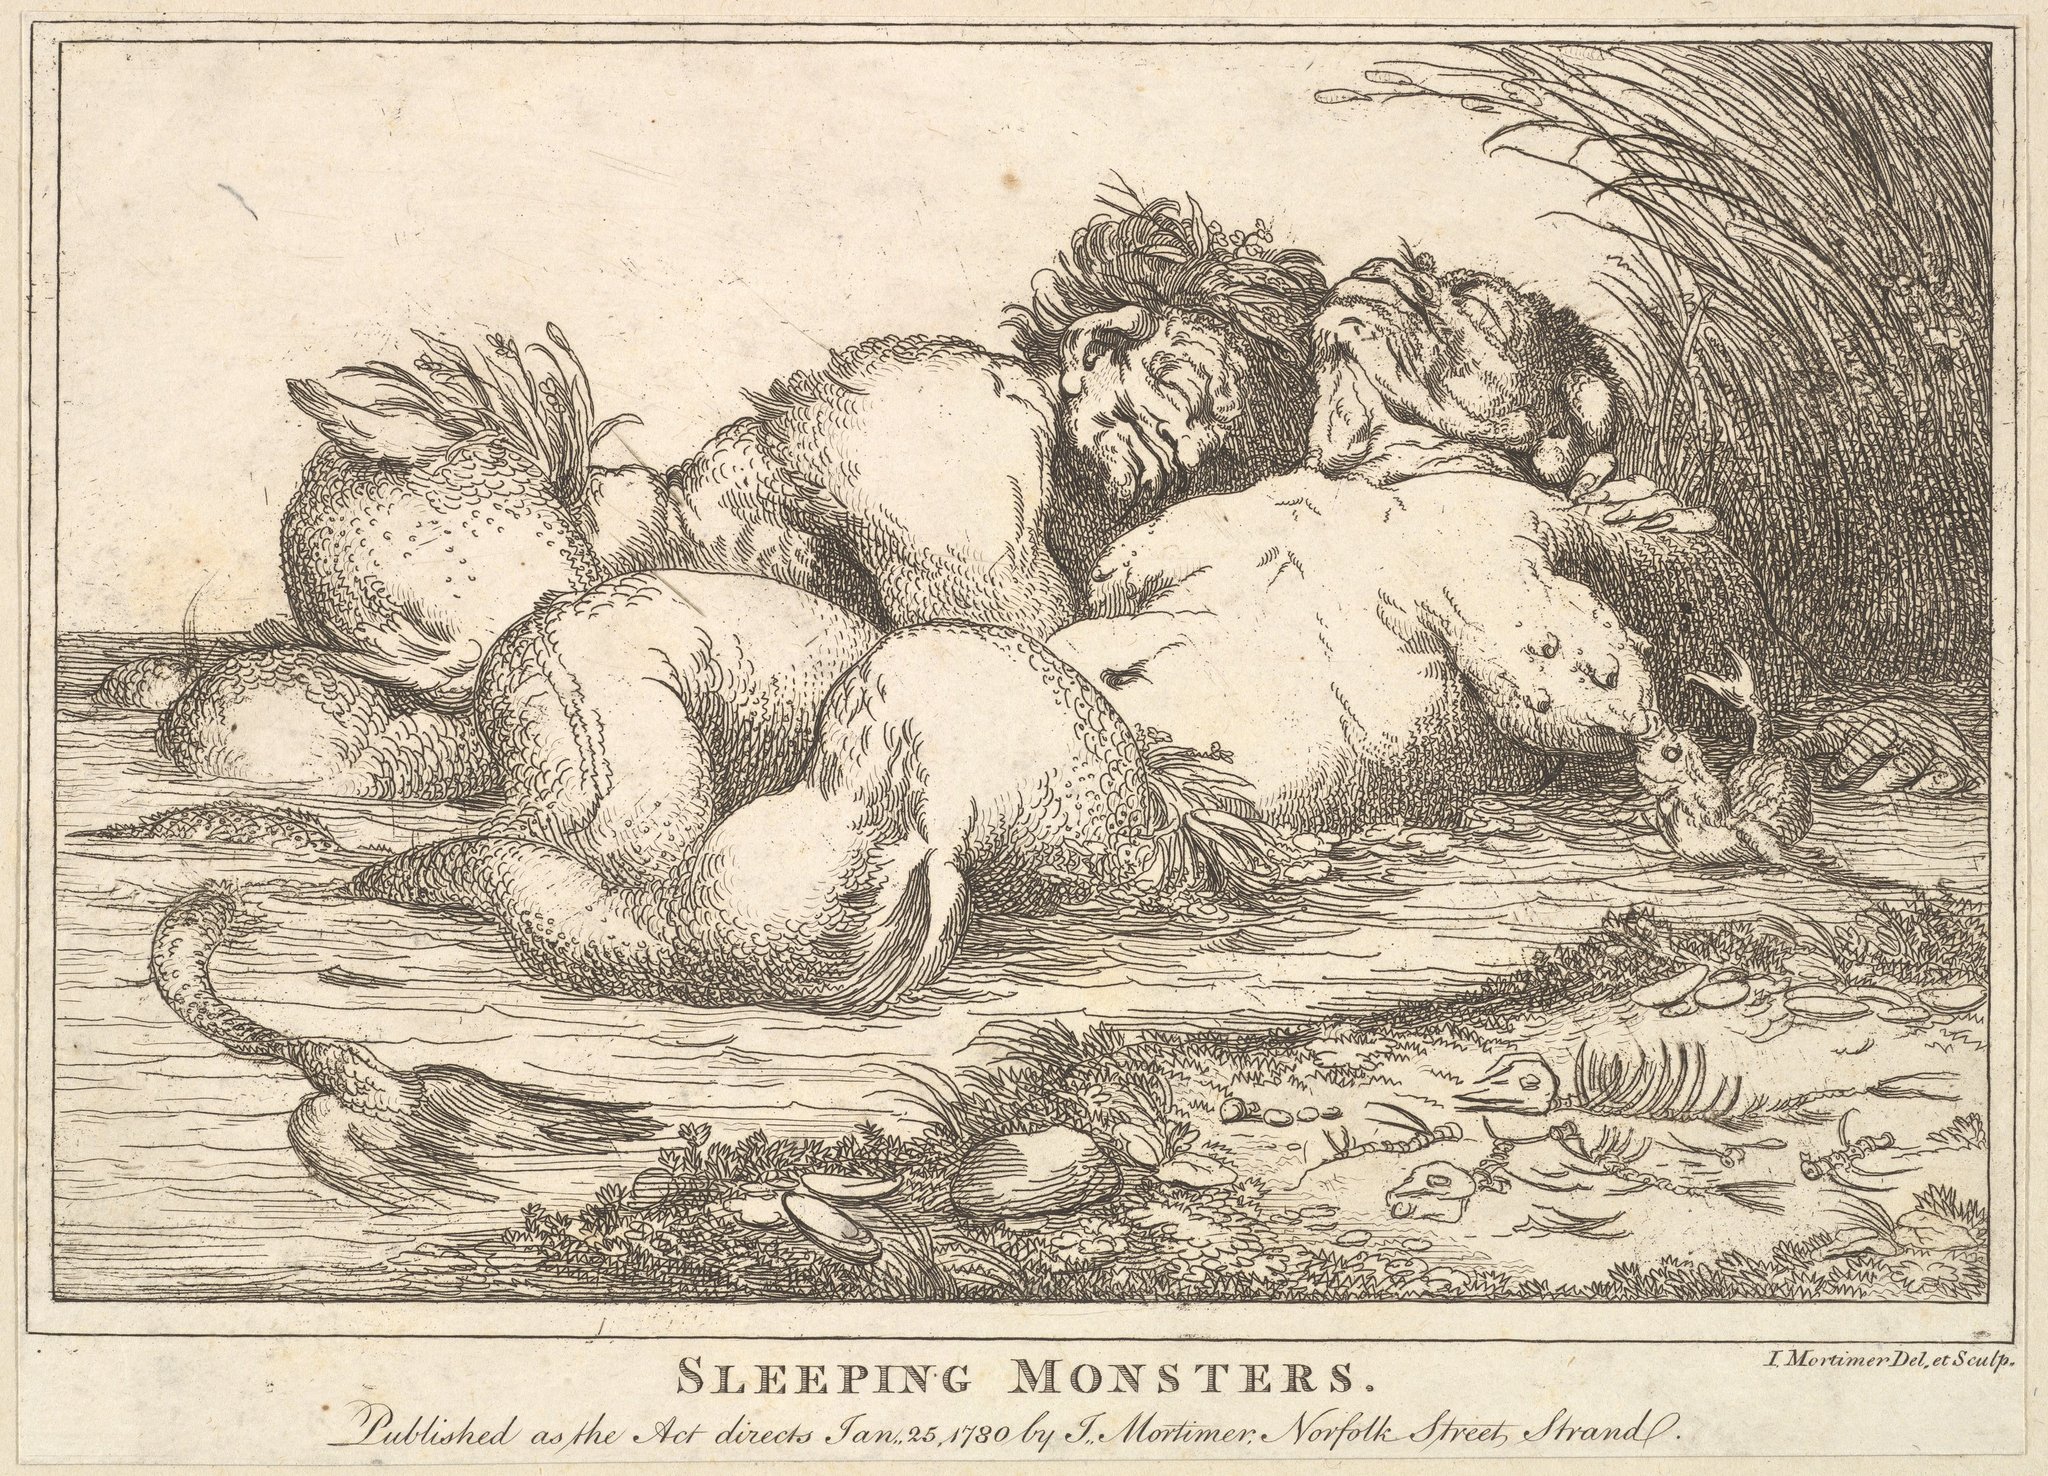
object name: print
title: Sleeping Monsters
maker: john hamilton mortimer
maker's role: artist and publisher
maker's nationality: british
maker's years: 1740-1779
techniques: etching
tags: sleeping,monsters